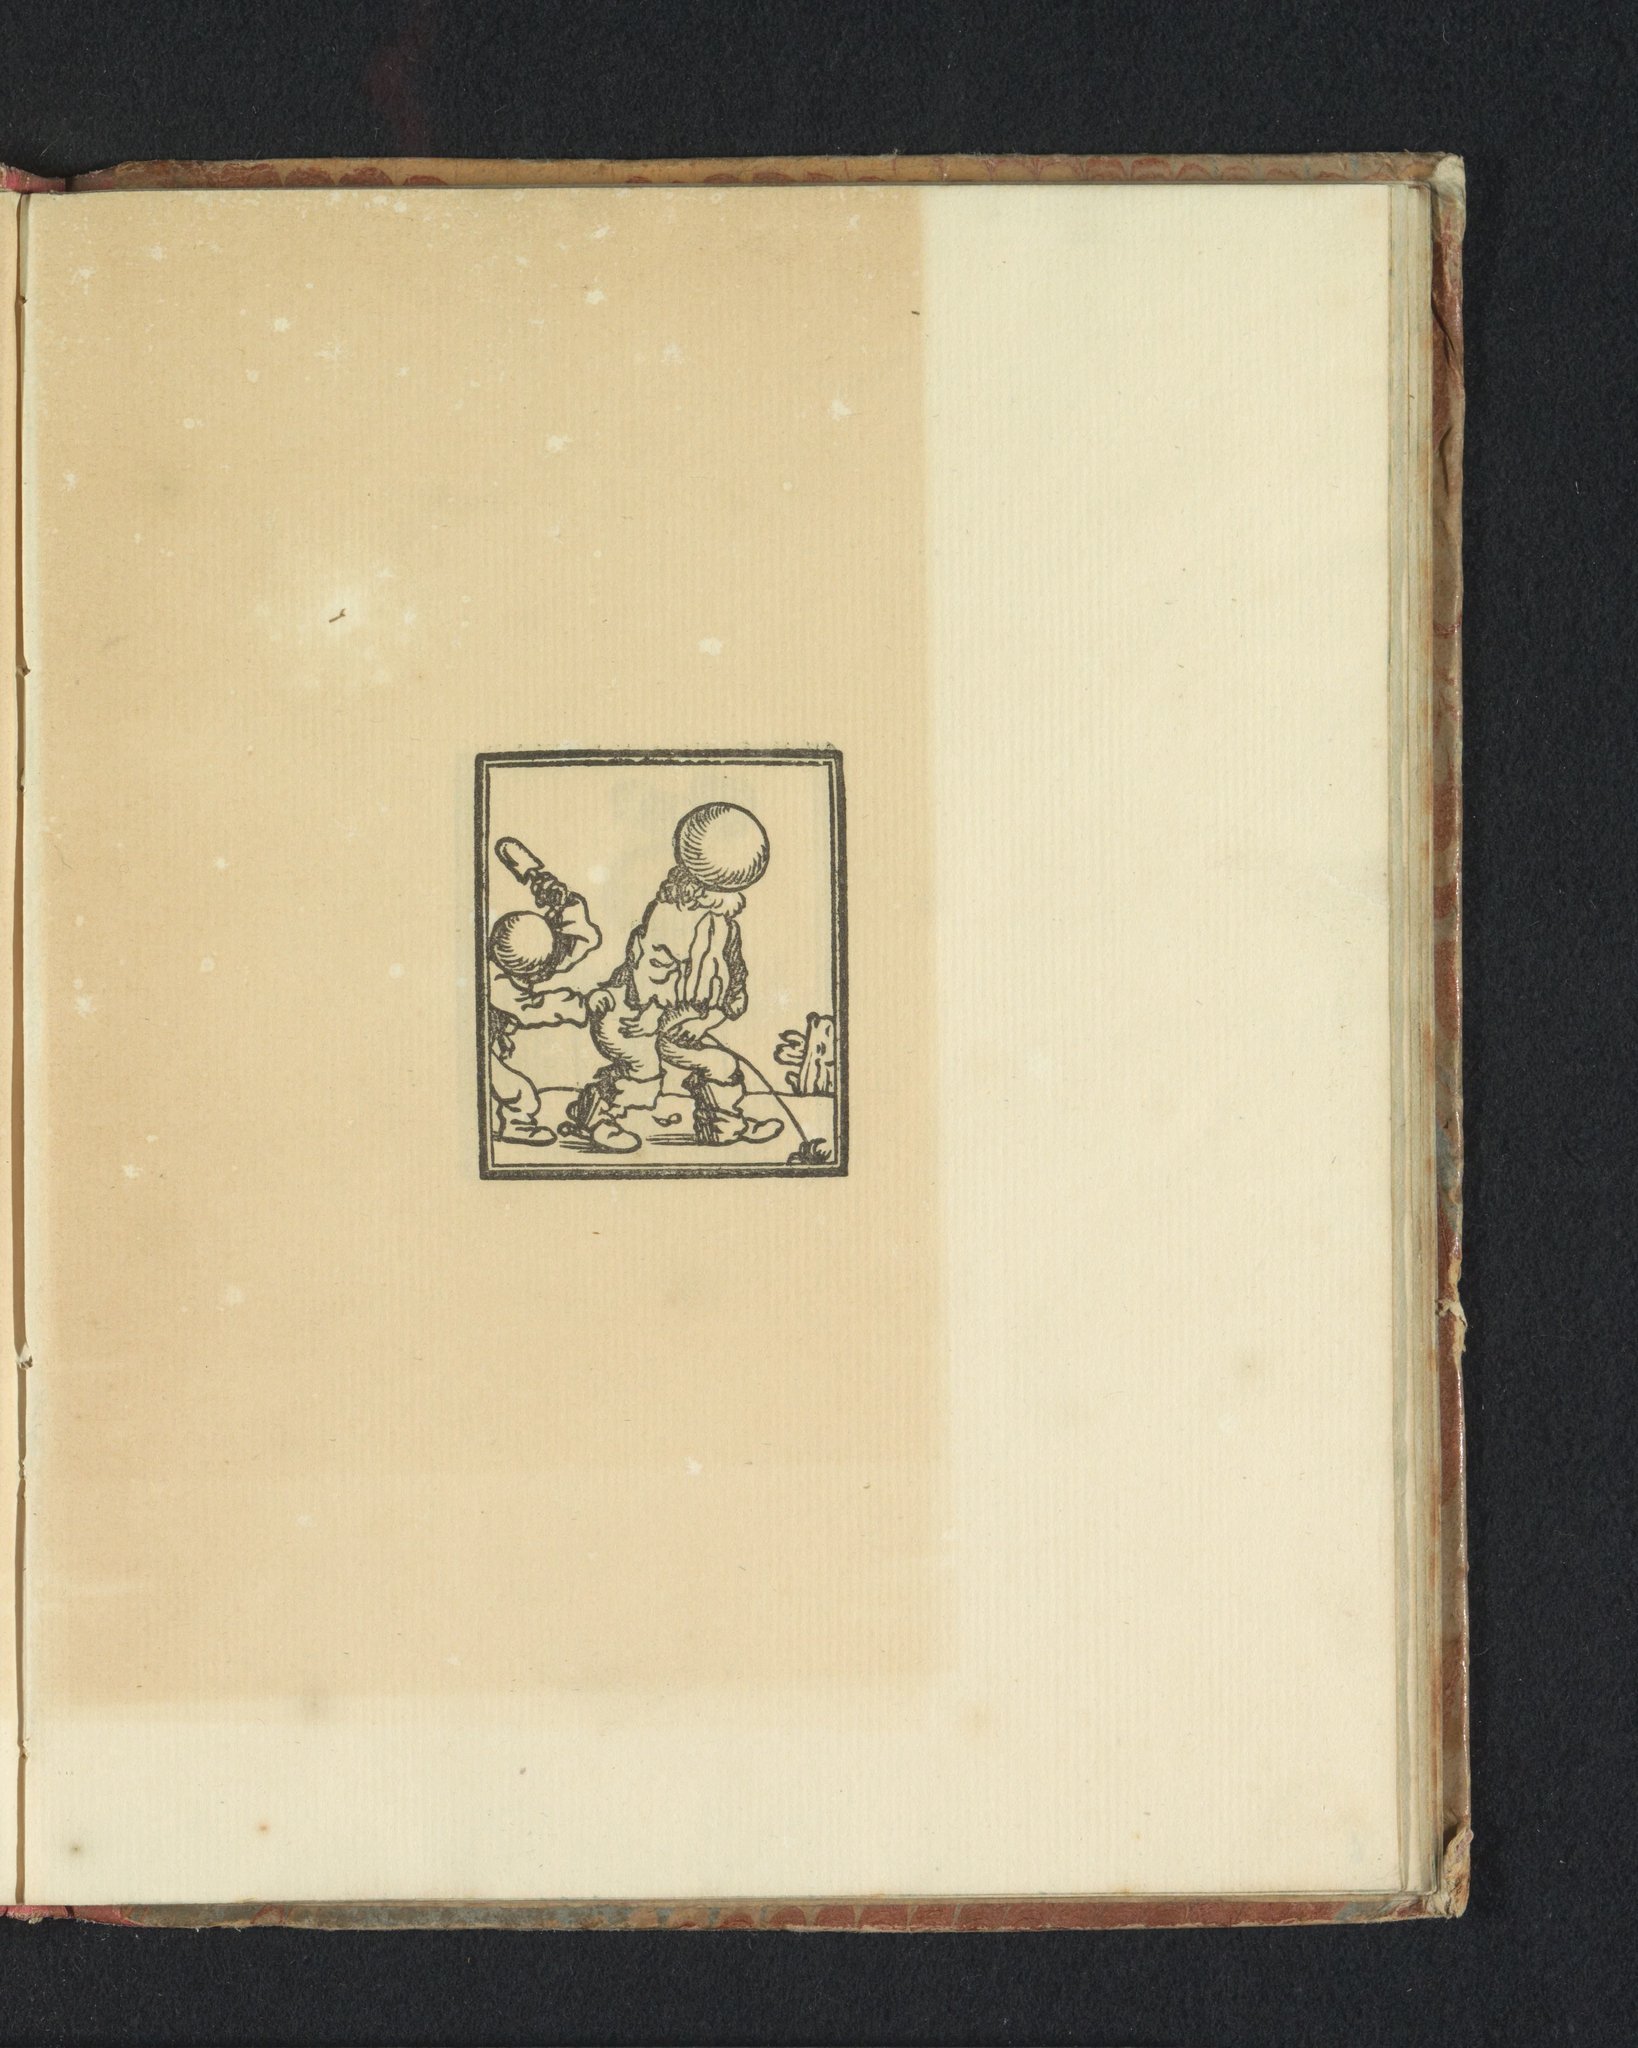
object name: print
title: Klootjes volk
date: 1731-1732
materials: paper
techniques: woodcut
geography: haarlem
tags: caricatures (human types)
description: Koddige figuur, in het onderschrift in de overzichtsprent draagt deze figuur de naam: Klootjes volk. Onderdeel van het boekje: XXXVI. aartige figuuren, geinventeert door Izaak van Ostade tot Haarlem [1731-1732].